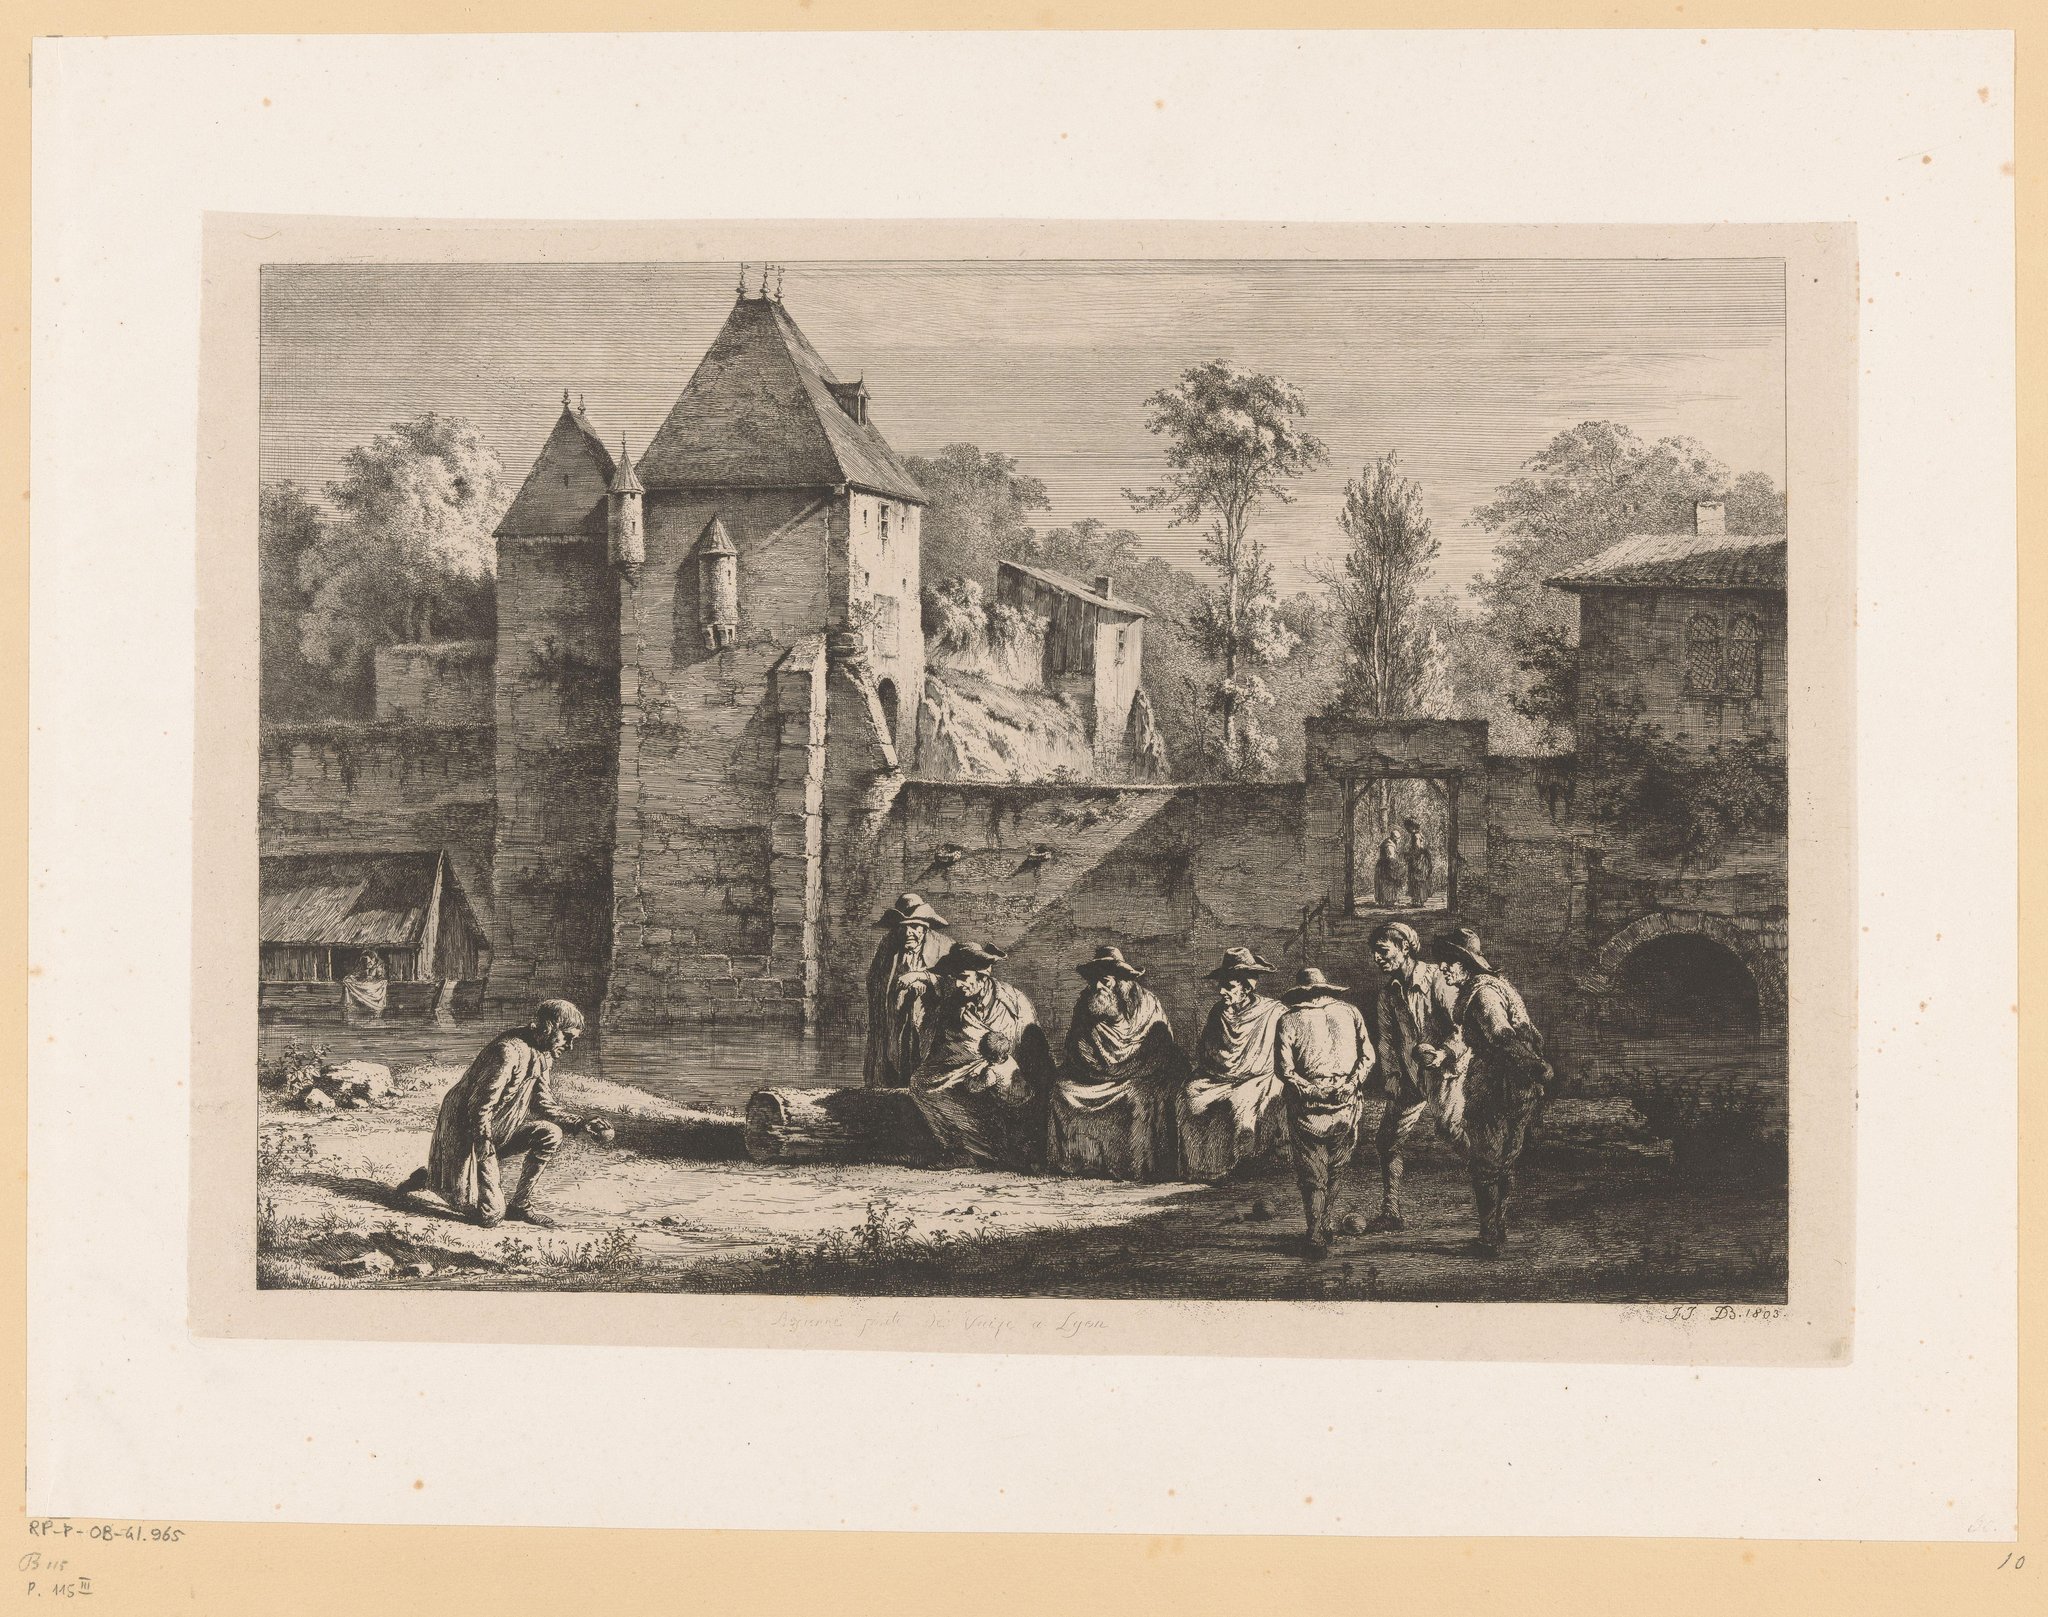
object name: print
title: Balspelende mannen bij de oude Porte de Vaise te Lyon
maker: jean jacques de boissieu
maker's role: draughtsman, print maker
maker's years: 1736-1810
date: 1803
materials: paper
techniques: drypoint, etching, roulette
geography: france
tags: 'jeu de boules', city-gate, lyon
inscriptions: collector's mark: Lugt 12